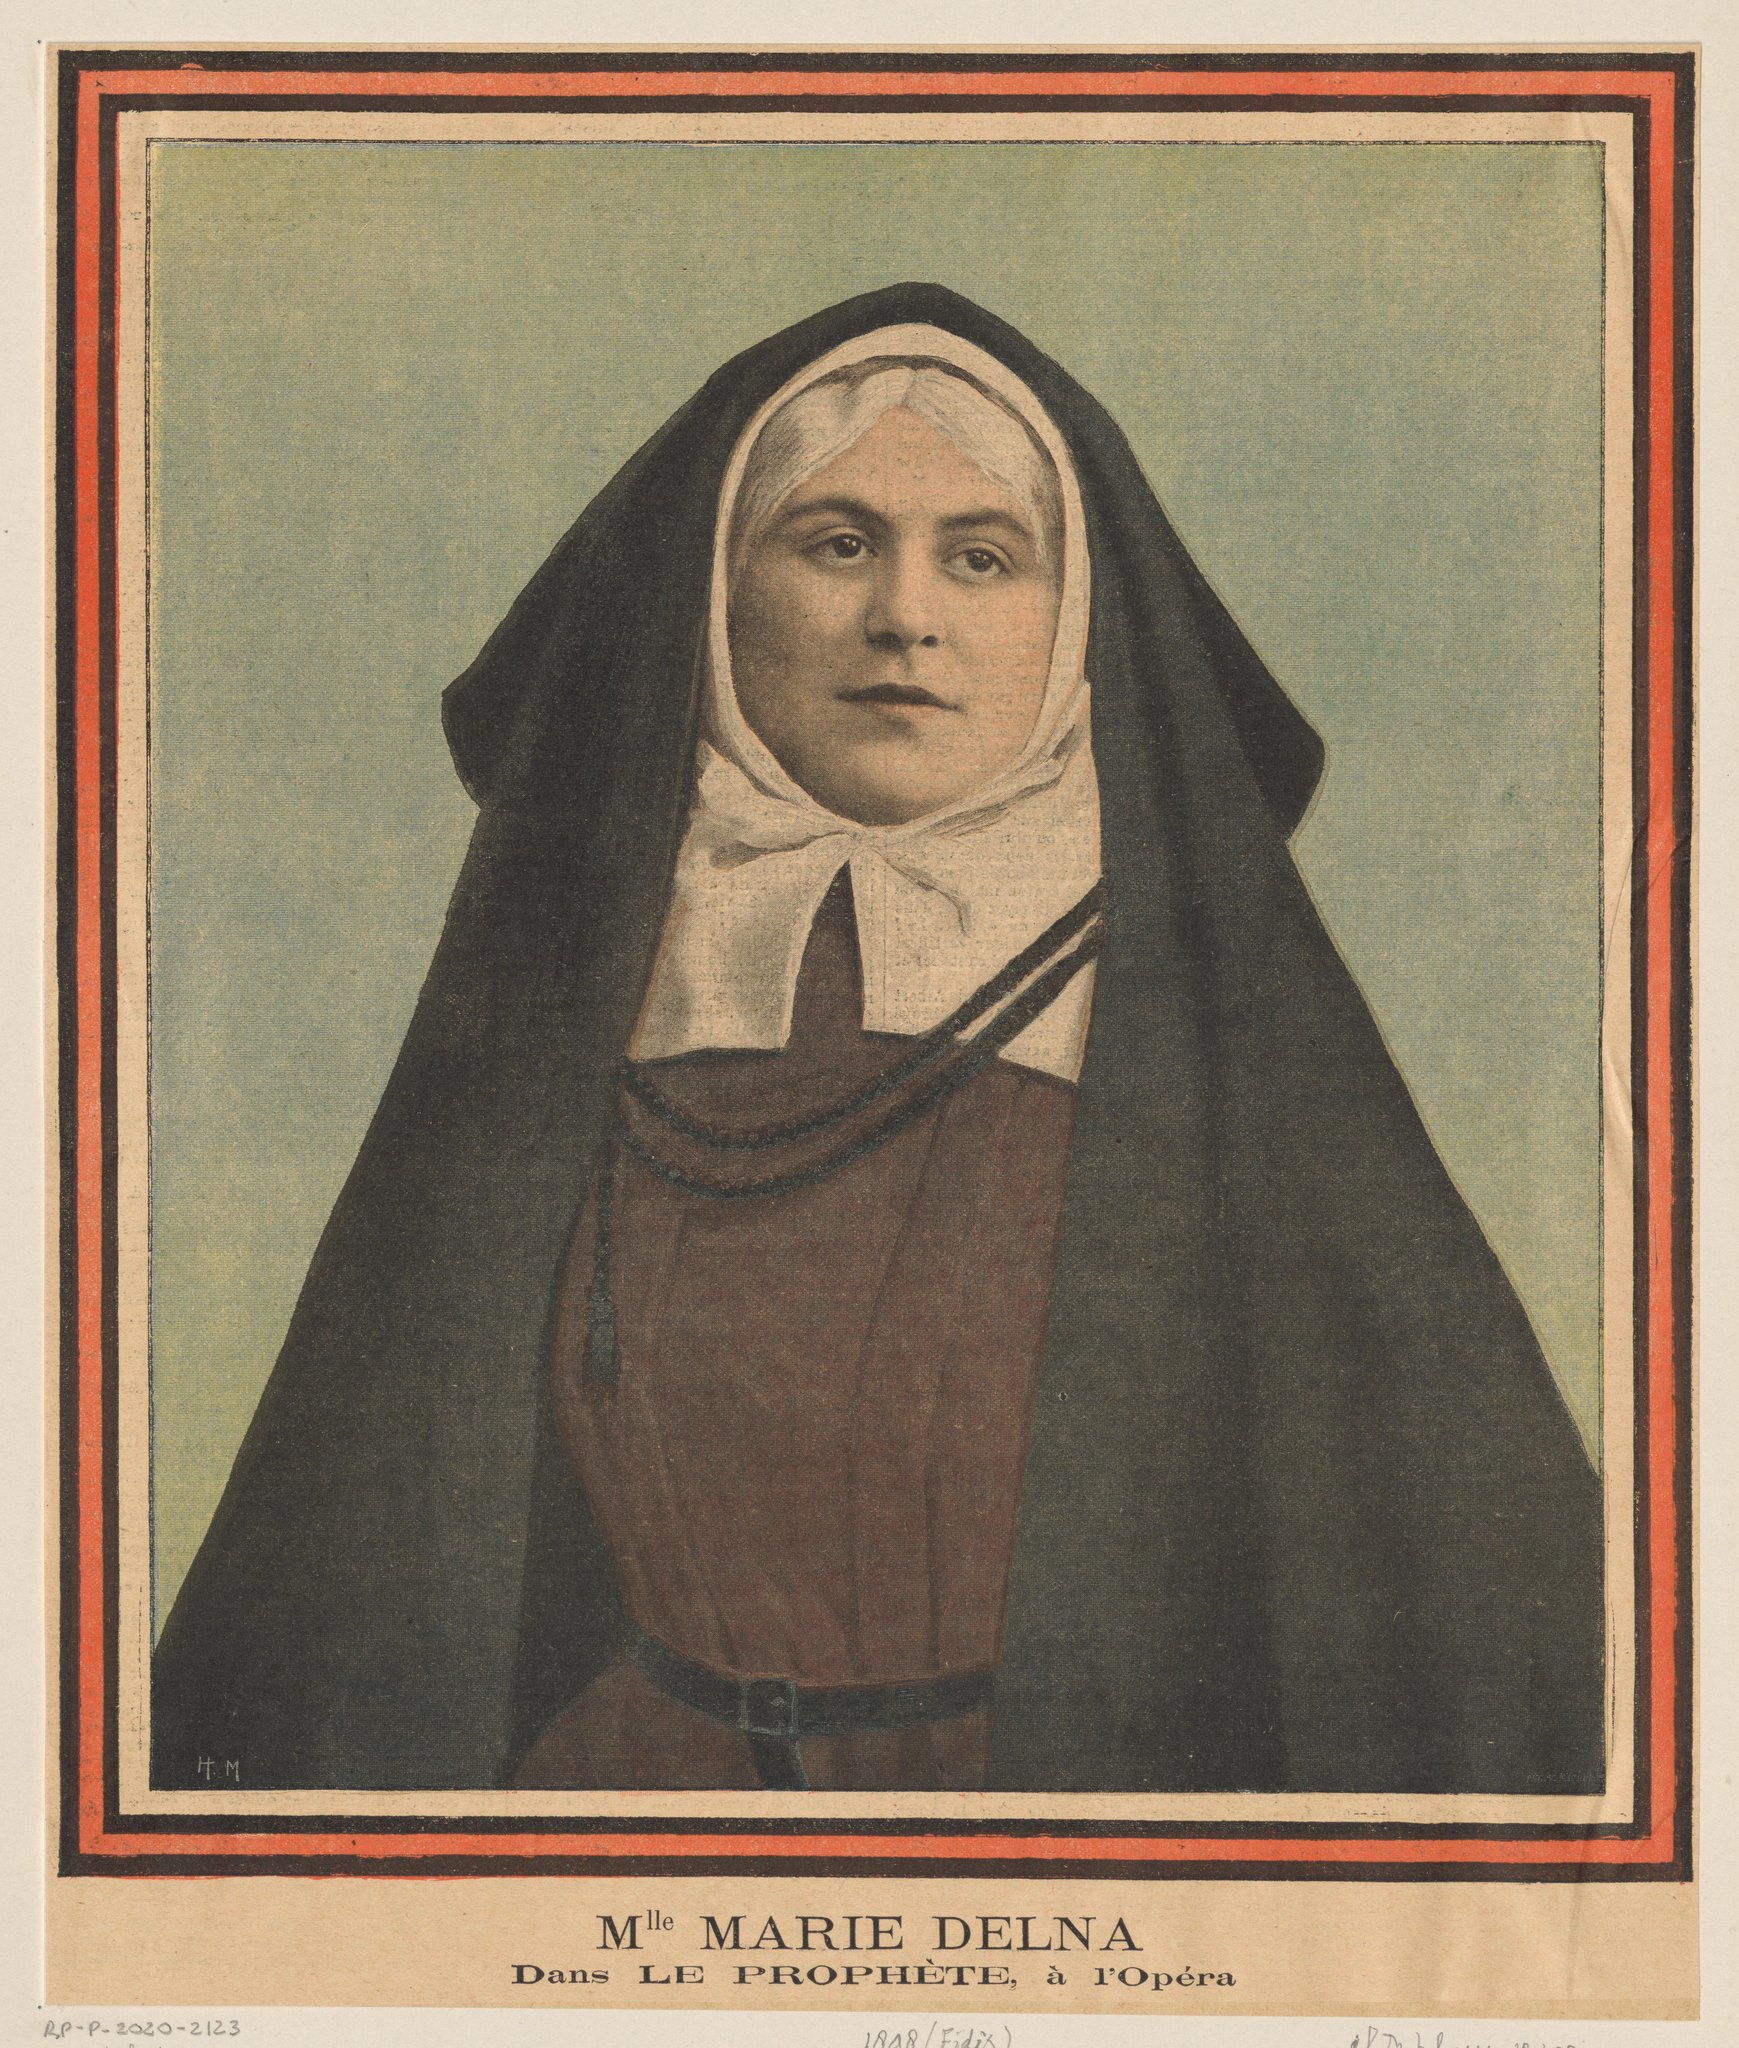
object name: photomechanical print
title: Portret van Marie Delna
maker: Anonymous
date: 1898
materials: paper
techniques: letterpress printing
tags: paris, historical persons - bb - woman, historical persons, portrait of opera-singer, opera-singer (female)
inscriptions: monogram: ‘H.M’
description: Prent uit: Le Petit Journal. Supplément du dimanche 9 (1898), nr. 393, 29 mei 1898.